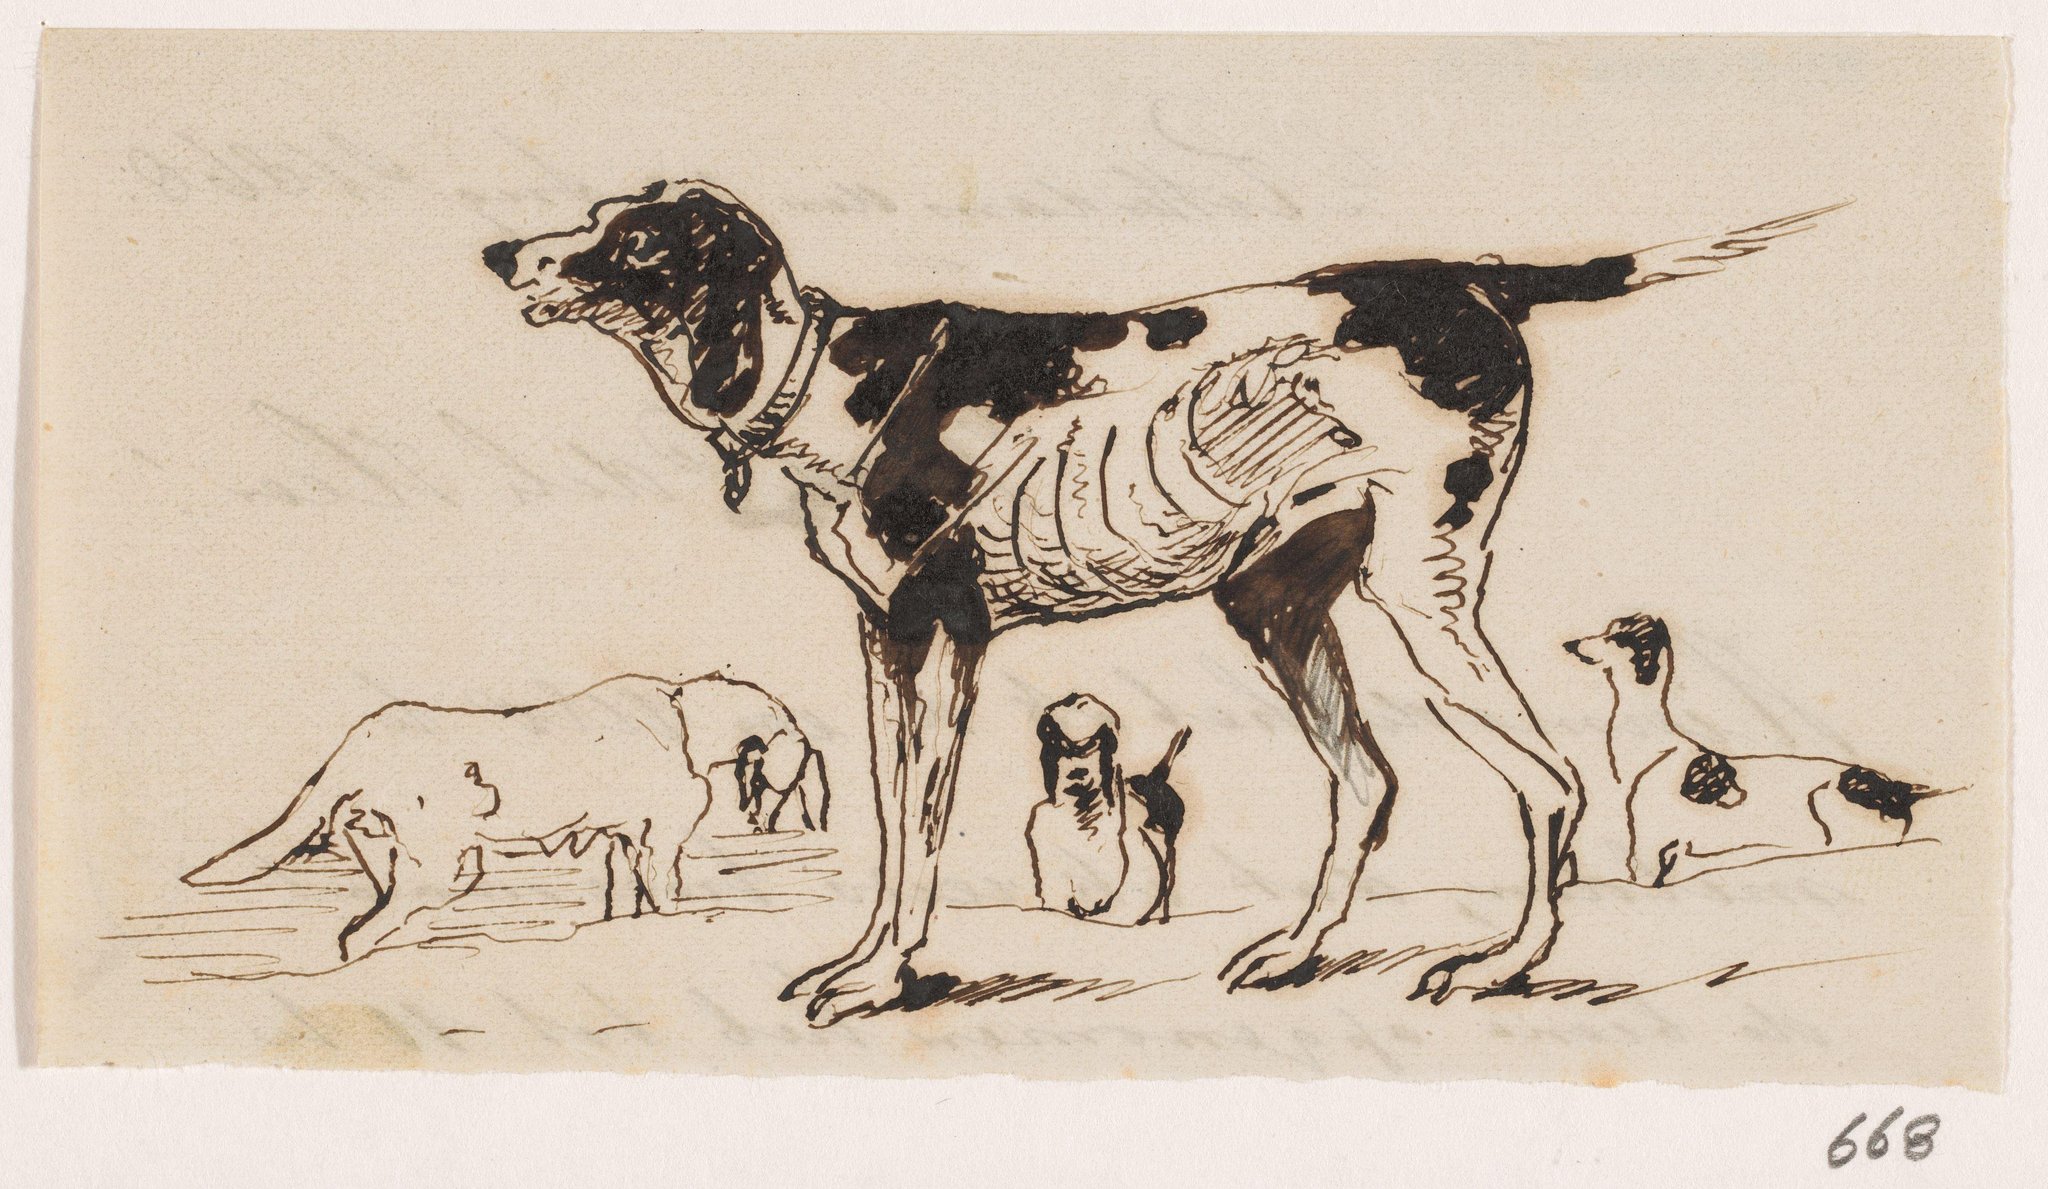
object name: drawing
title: Jachthonden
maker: johannes tavenraat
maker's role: draughtsman, painter, print maker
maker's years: 1809-1881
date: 1868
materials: ink, paper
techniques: pen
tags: hunting dogs, dog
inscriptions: collector's mark: Lugt 2228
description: Jachthonden. Getekend op de achterzijde van een fragment van een brief, gedateerd 25 augustus 1868.